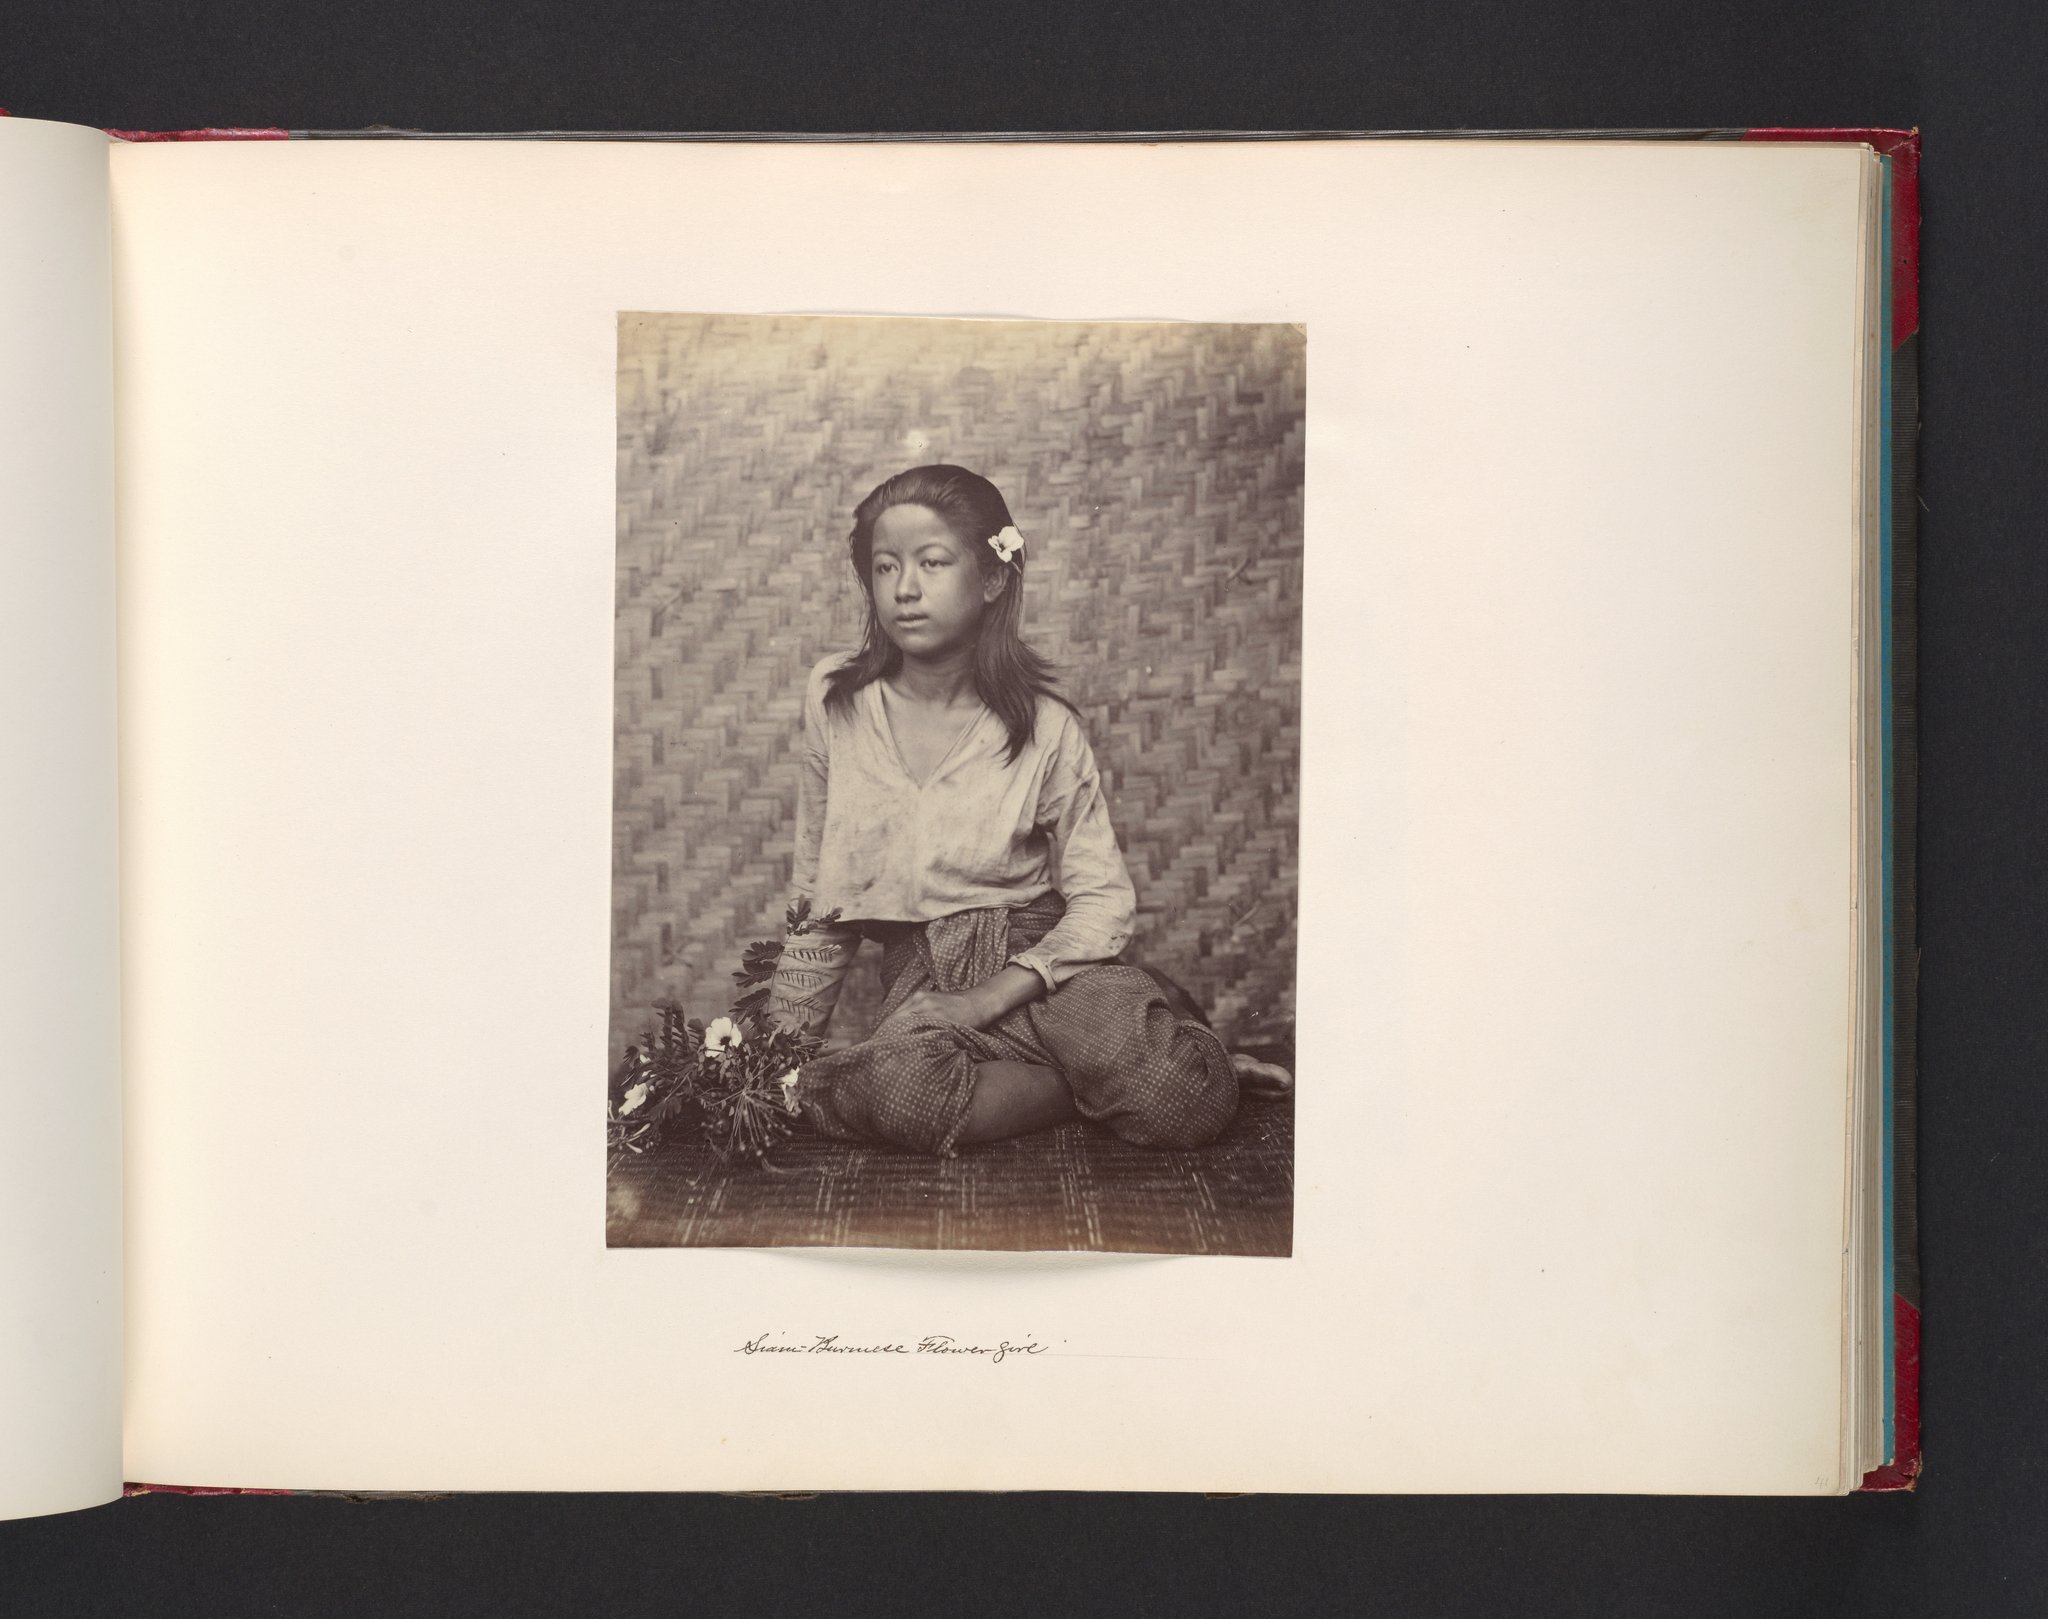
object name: photograph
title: Siam - Burmese Flower Girl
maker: john thomson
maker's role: artist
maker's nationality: british, scottish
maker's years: 1837-1921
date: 1865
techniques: albumen silver print, glass negative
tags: girls,portraits